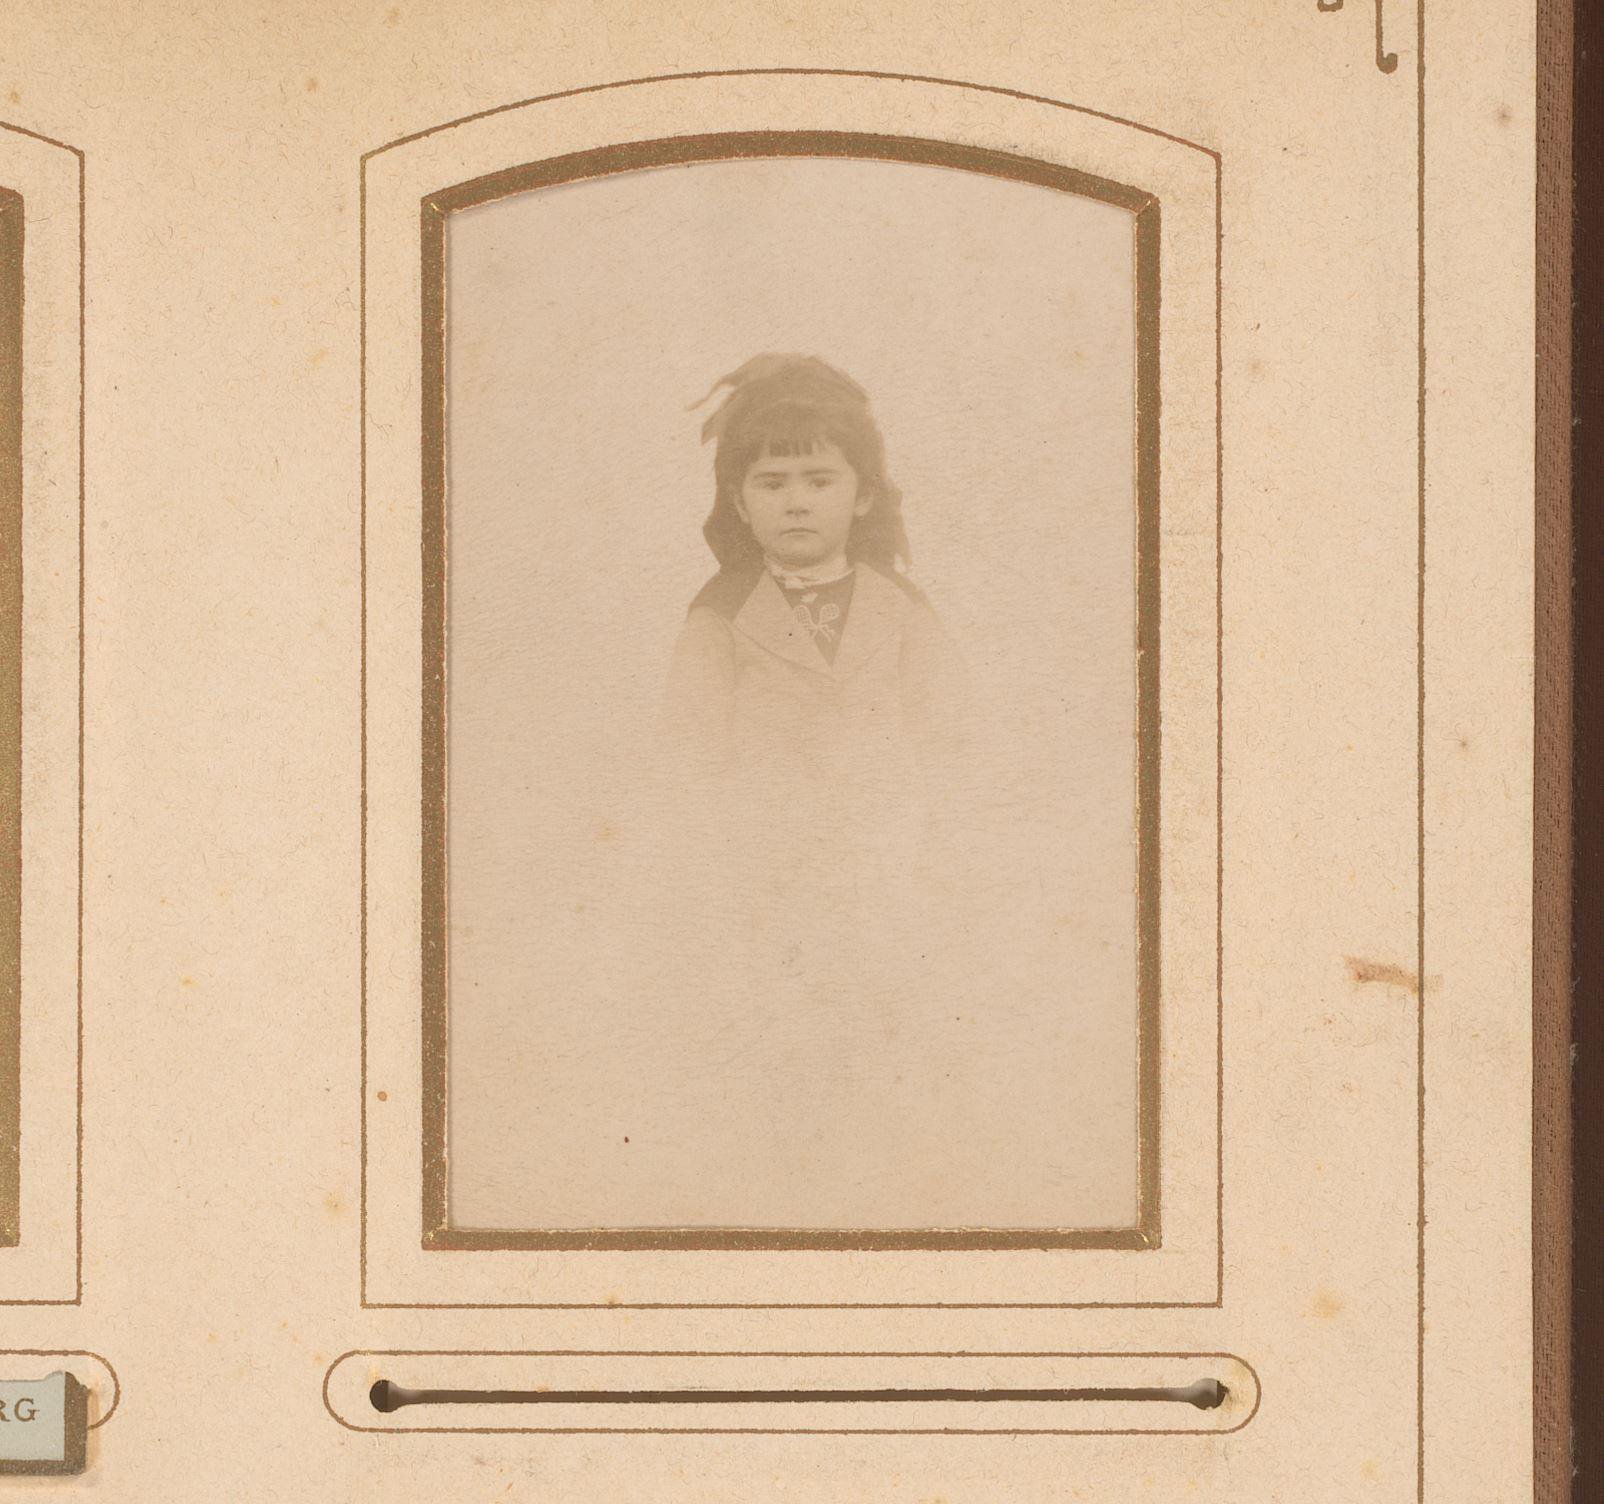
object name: carte de visite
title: Portret van een meisje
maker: Anonymous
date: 1860-1890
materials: cardboard, photographic support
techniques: albumen print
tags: historical persons - bb - woman, girl (child between toddler and youth)